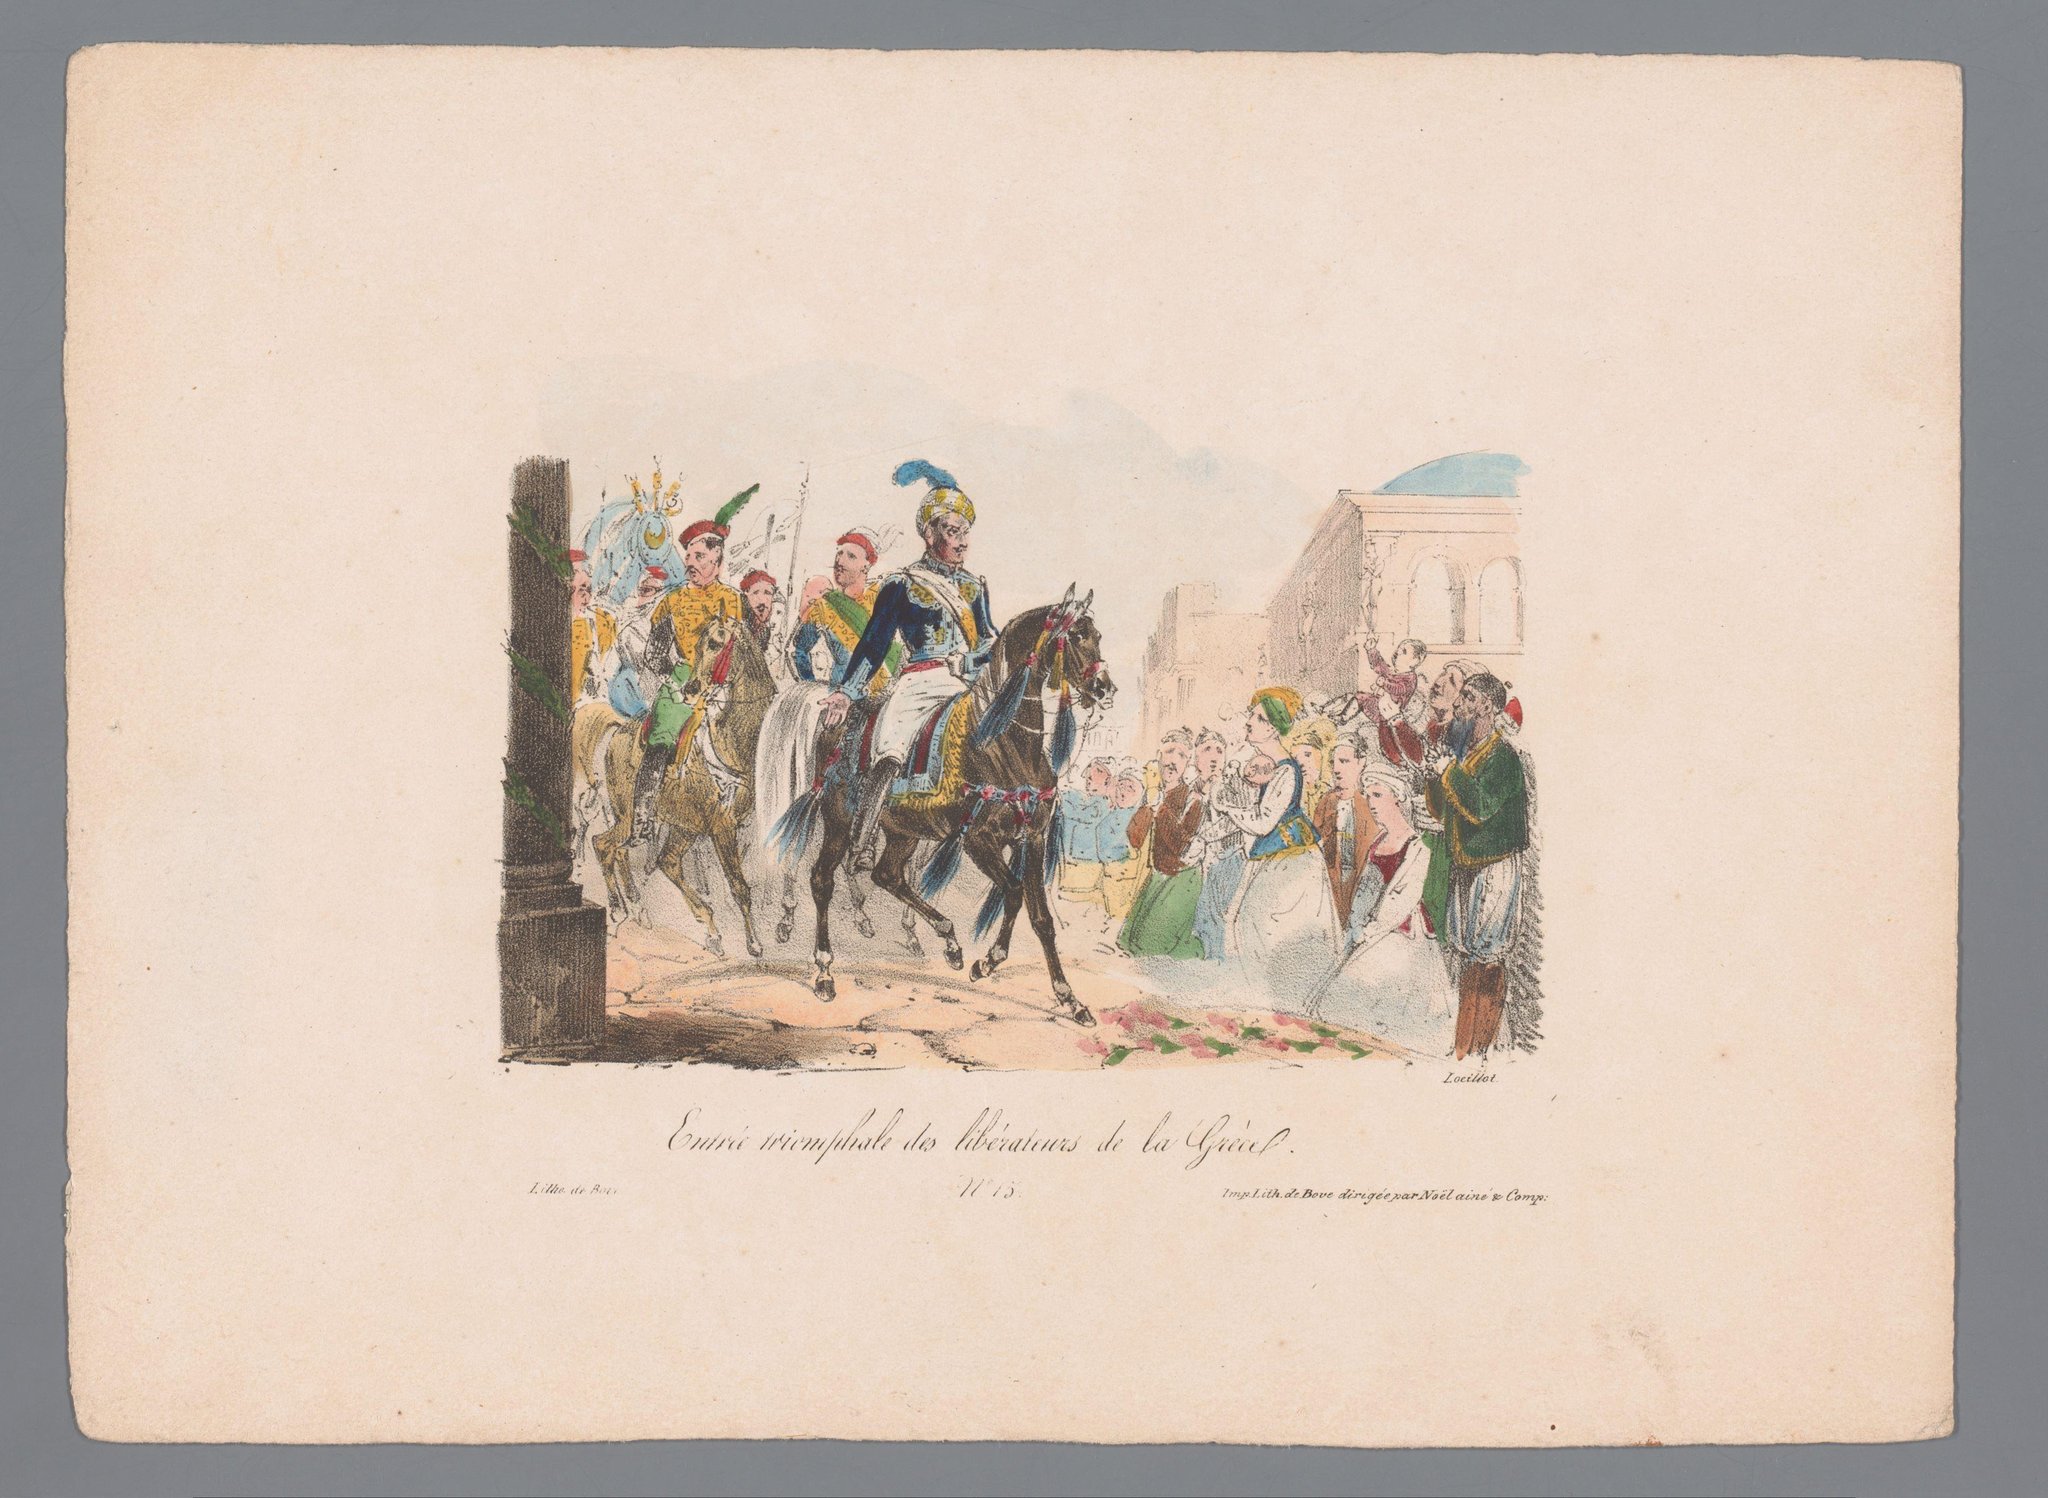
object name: print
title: Triomftocht door de bevrijders van Griekenland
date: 1829-1835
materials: paper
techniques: hand coloring, lithograph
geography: paris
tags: riding a horse, ass, or mule; rider, horseman, conqueror triumphing, triumphal entry of victor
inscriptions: collector's mark: Lugt 2228